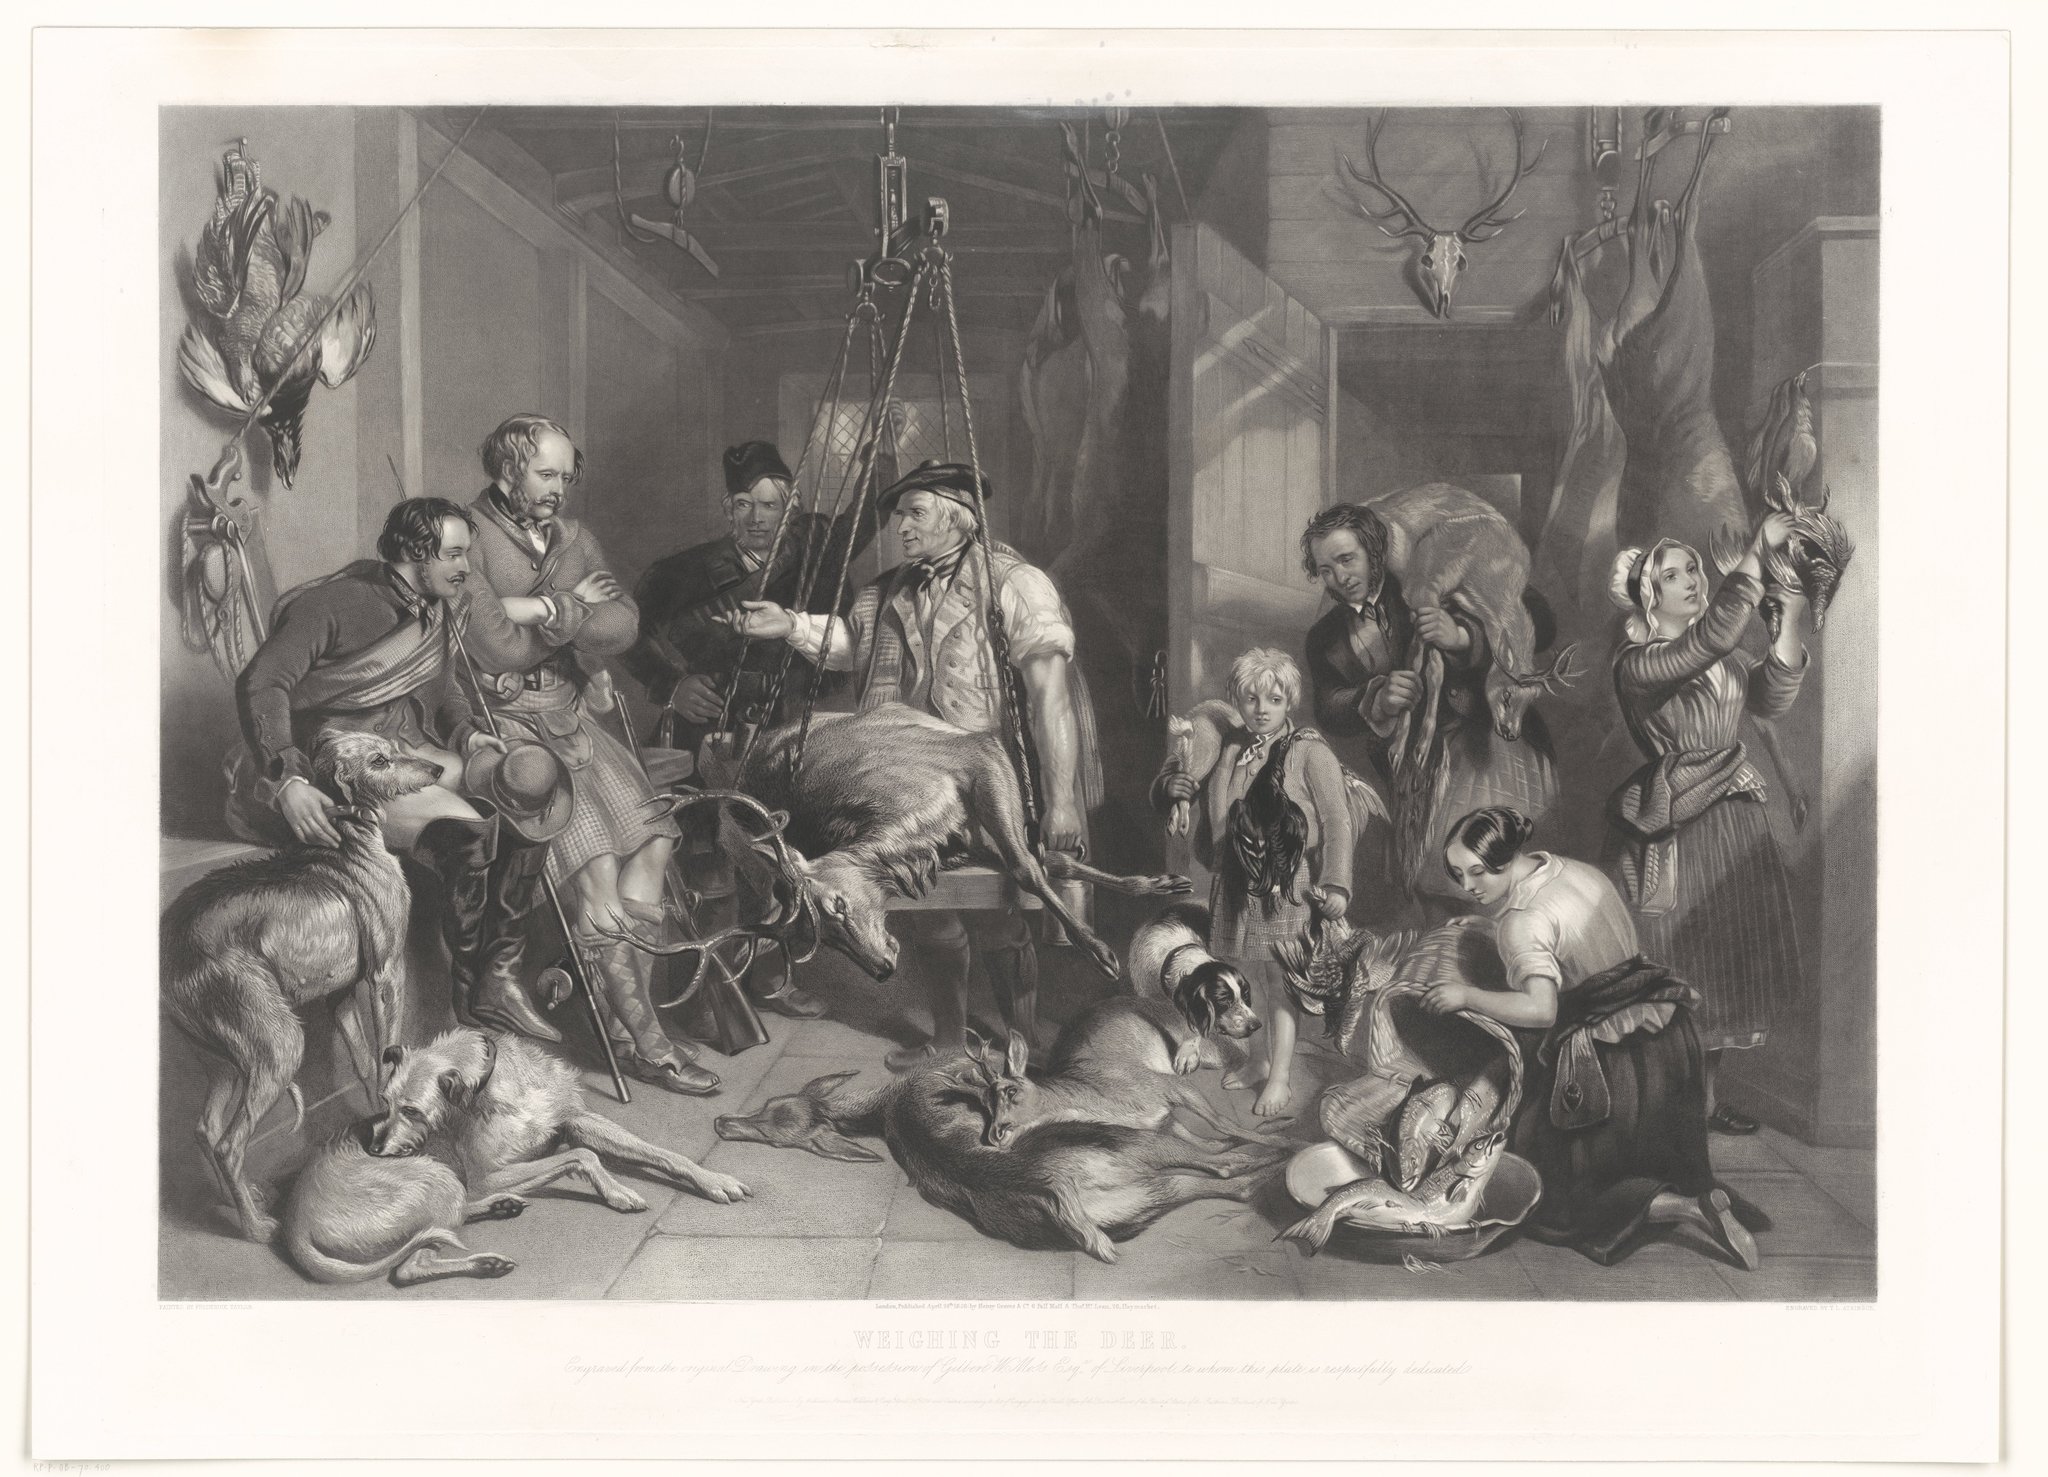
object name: print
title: "Weighing the Deer."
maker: thomas lewis atkinson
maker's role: print maker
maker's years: 1817-1889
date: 1827-1889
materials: paper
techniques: engraving